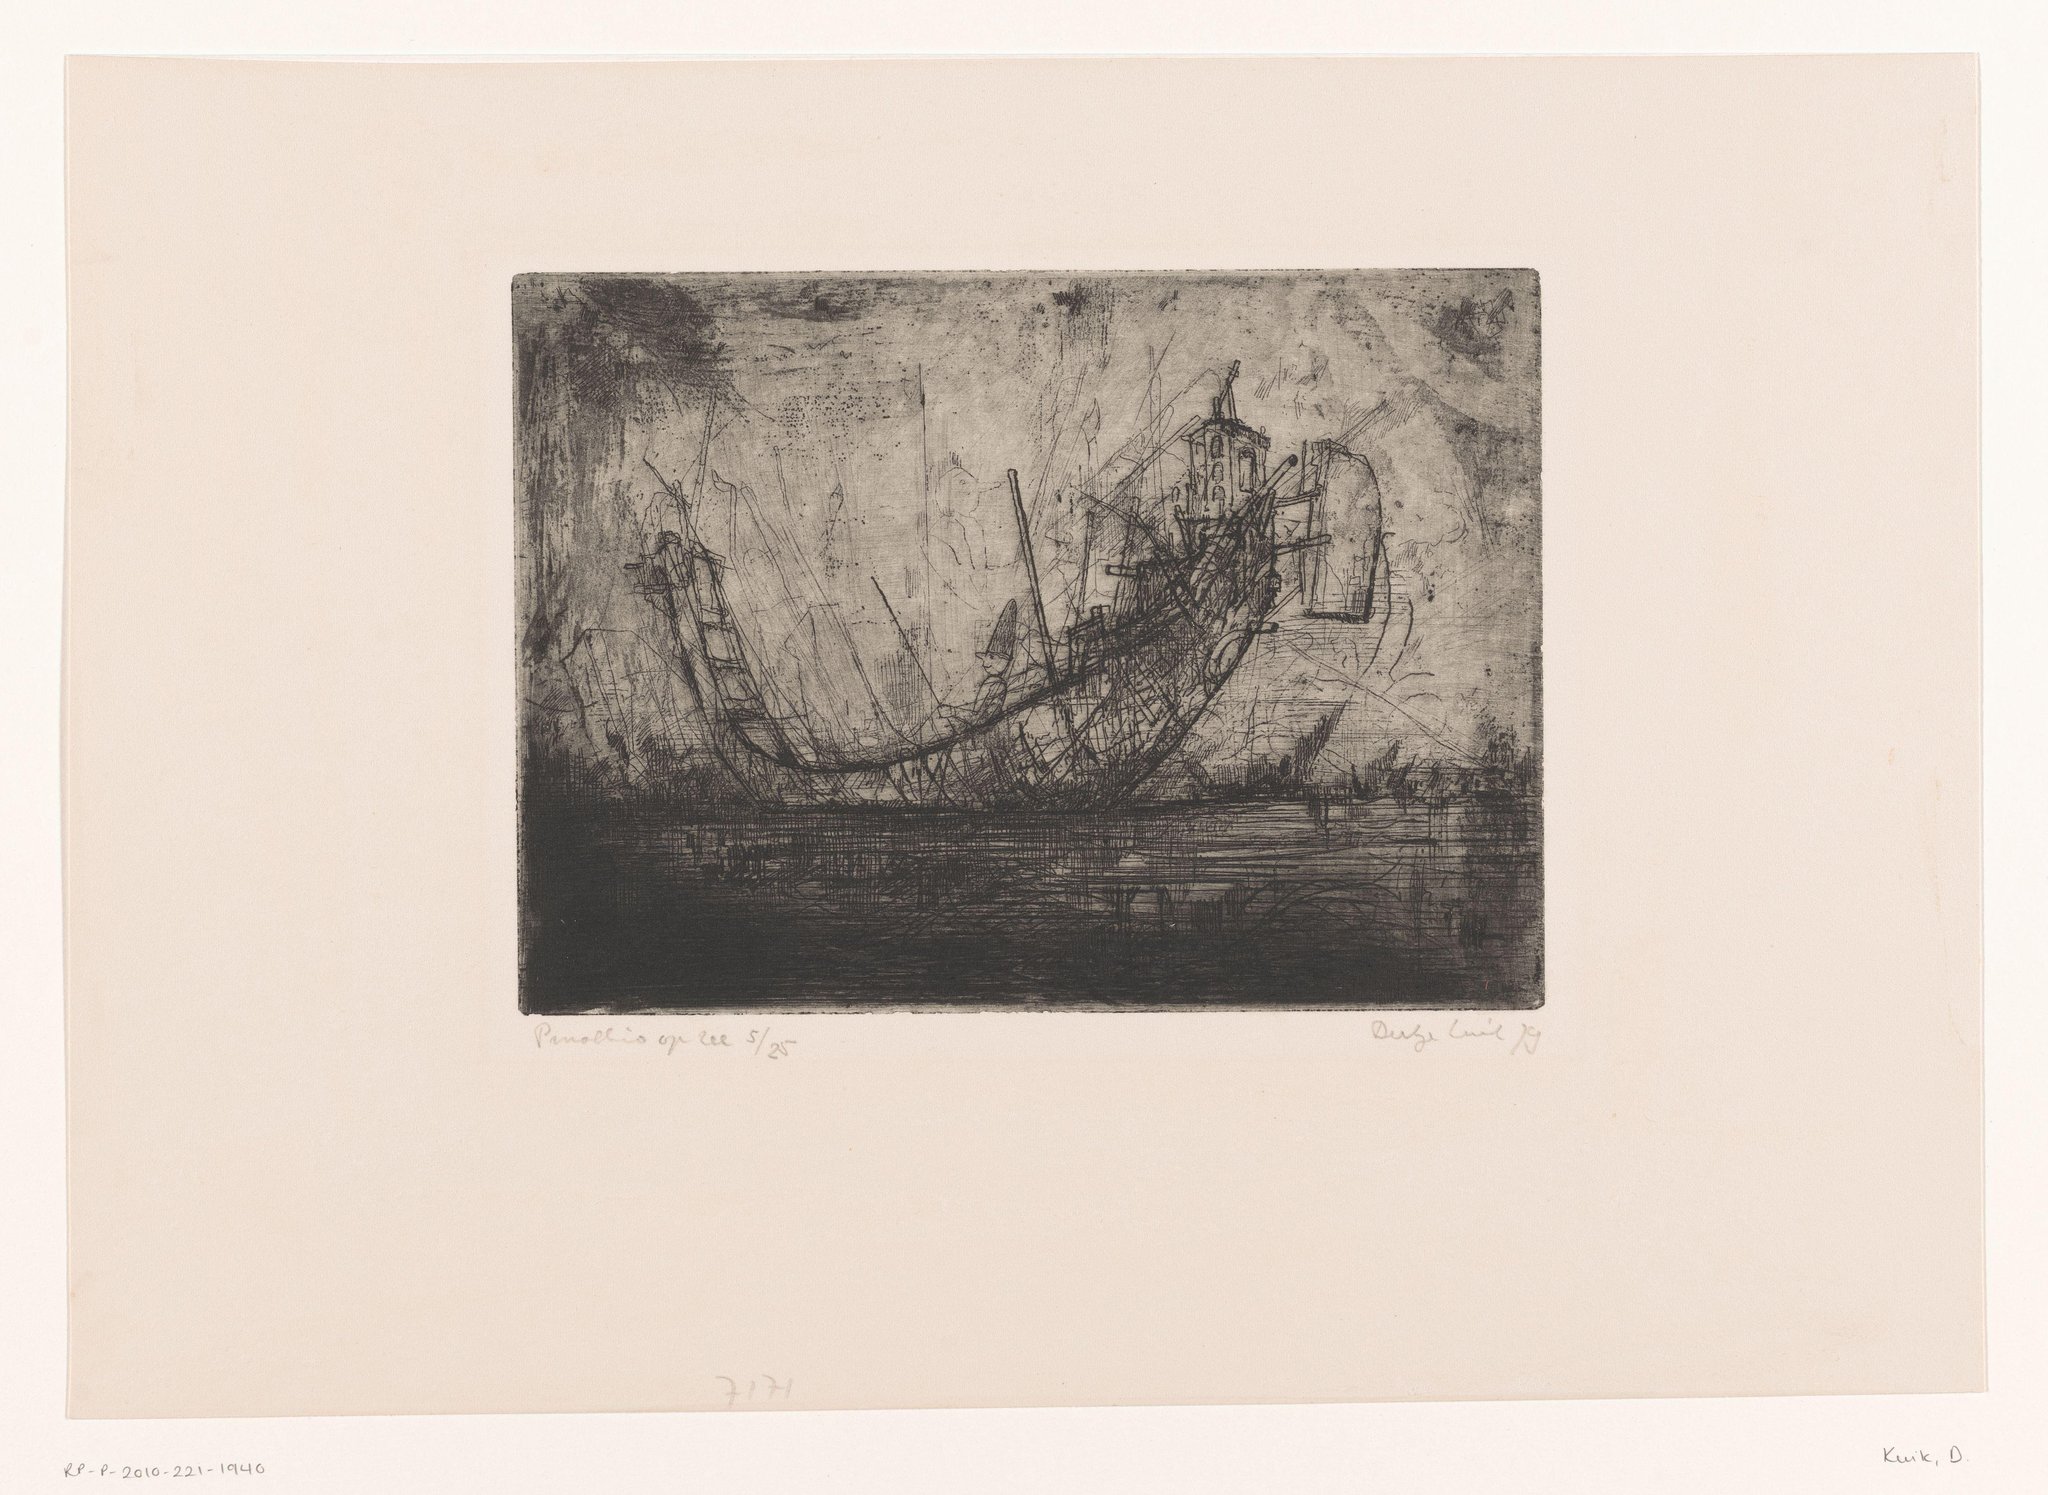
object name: print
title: Pinokkio op zee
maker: dirkje kuik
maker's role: print maker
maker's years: 1929-2008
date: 1979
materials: paper, ink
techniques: aquatint, etching, intaglio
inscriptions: edition: ‘5/25’, title: ‘Pinokkio op zee’, signature and date: ‘Dirkje Kuik 79’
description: Jongen met lange neus en puntmuts in een boot.